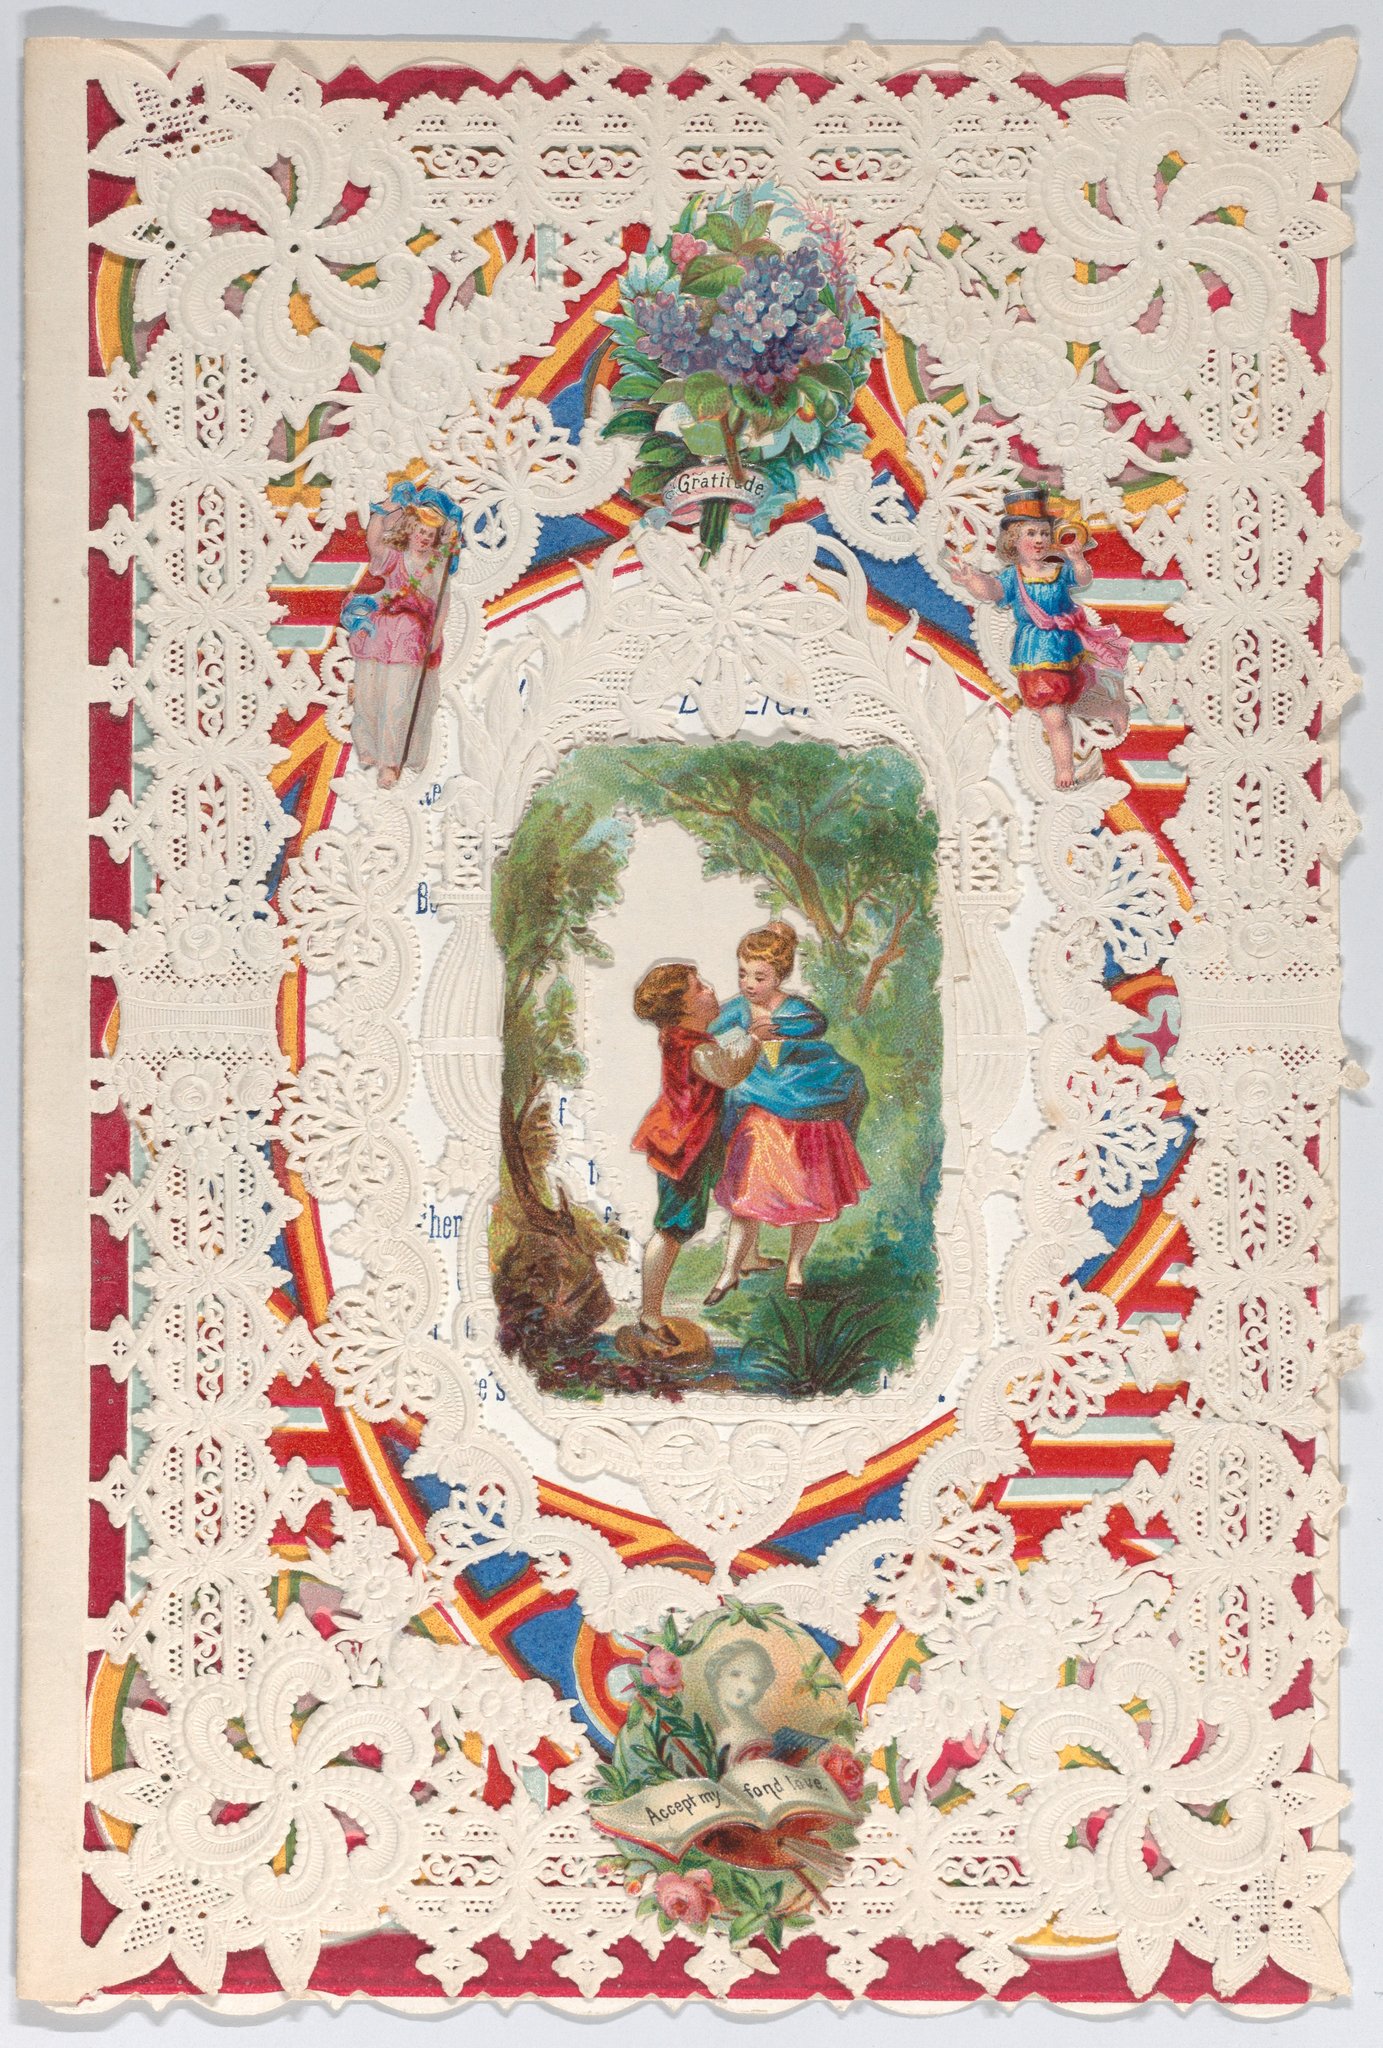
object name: valentine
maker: Anonymous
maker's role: artist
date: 1879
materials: lace, paper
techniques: chromolithography, embossing, open work